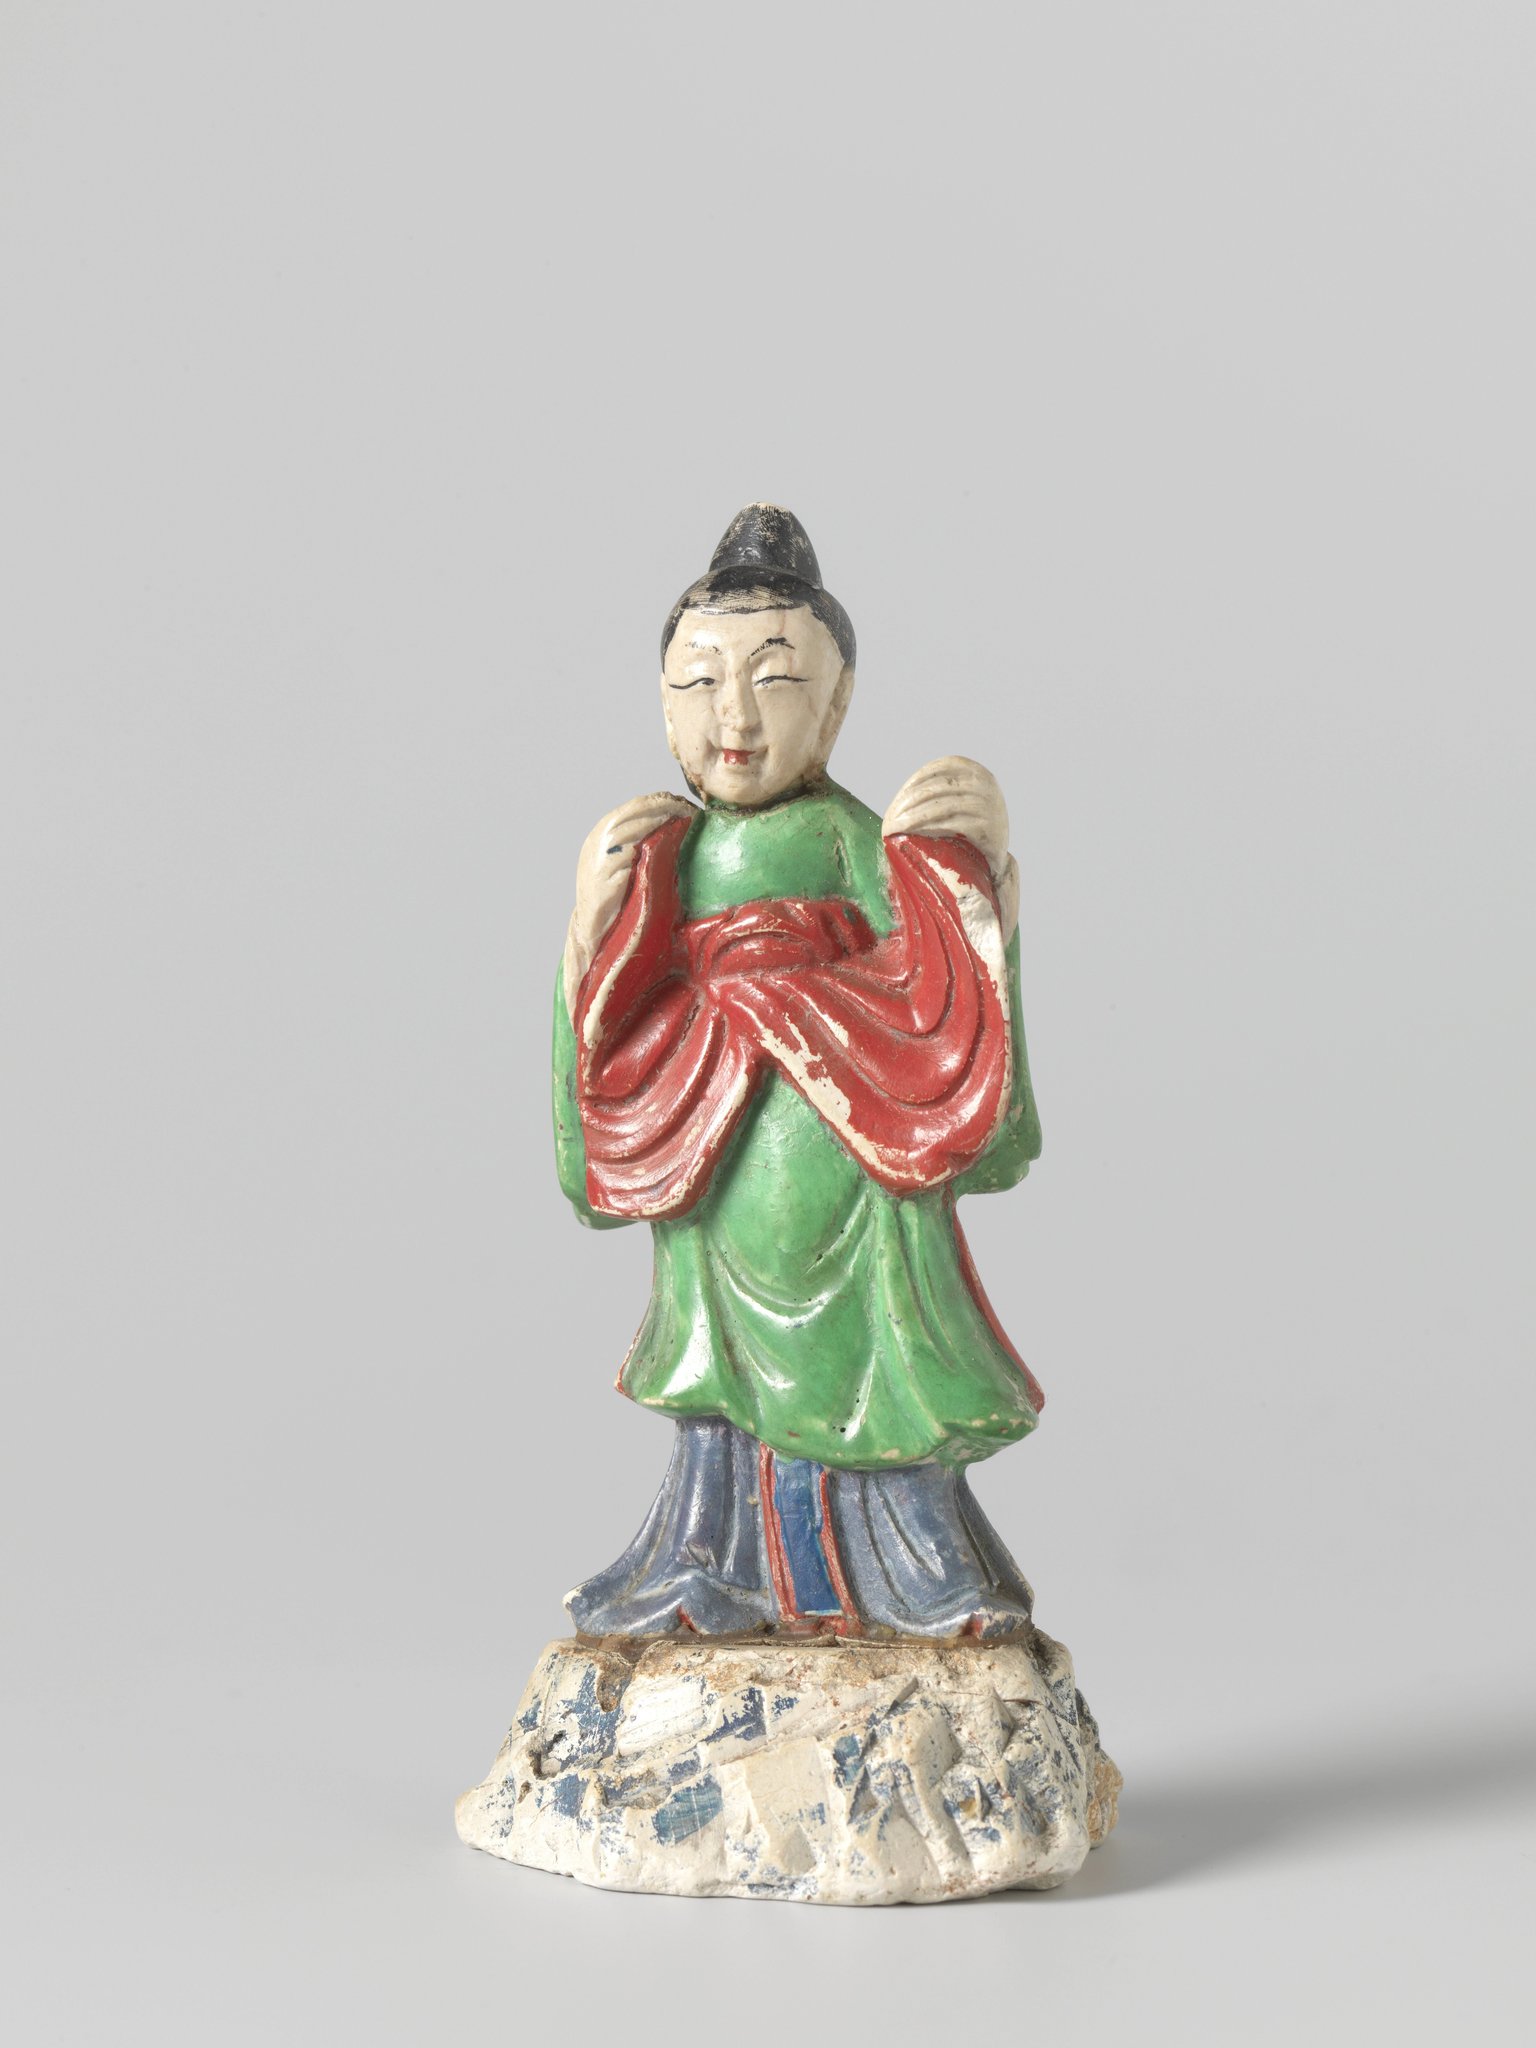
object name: vrouwenfiguur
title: Vrouwenfiguur in groen en rood gewaad en blauw onderkleed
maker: Anonymous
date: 1800-1900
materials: stone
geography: japan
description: Vrouwenfiguur in groen en rood gewaad en blauw onderkleed. Op gips voetstuk.